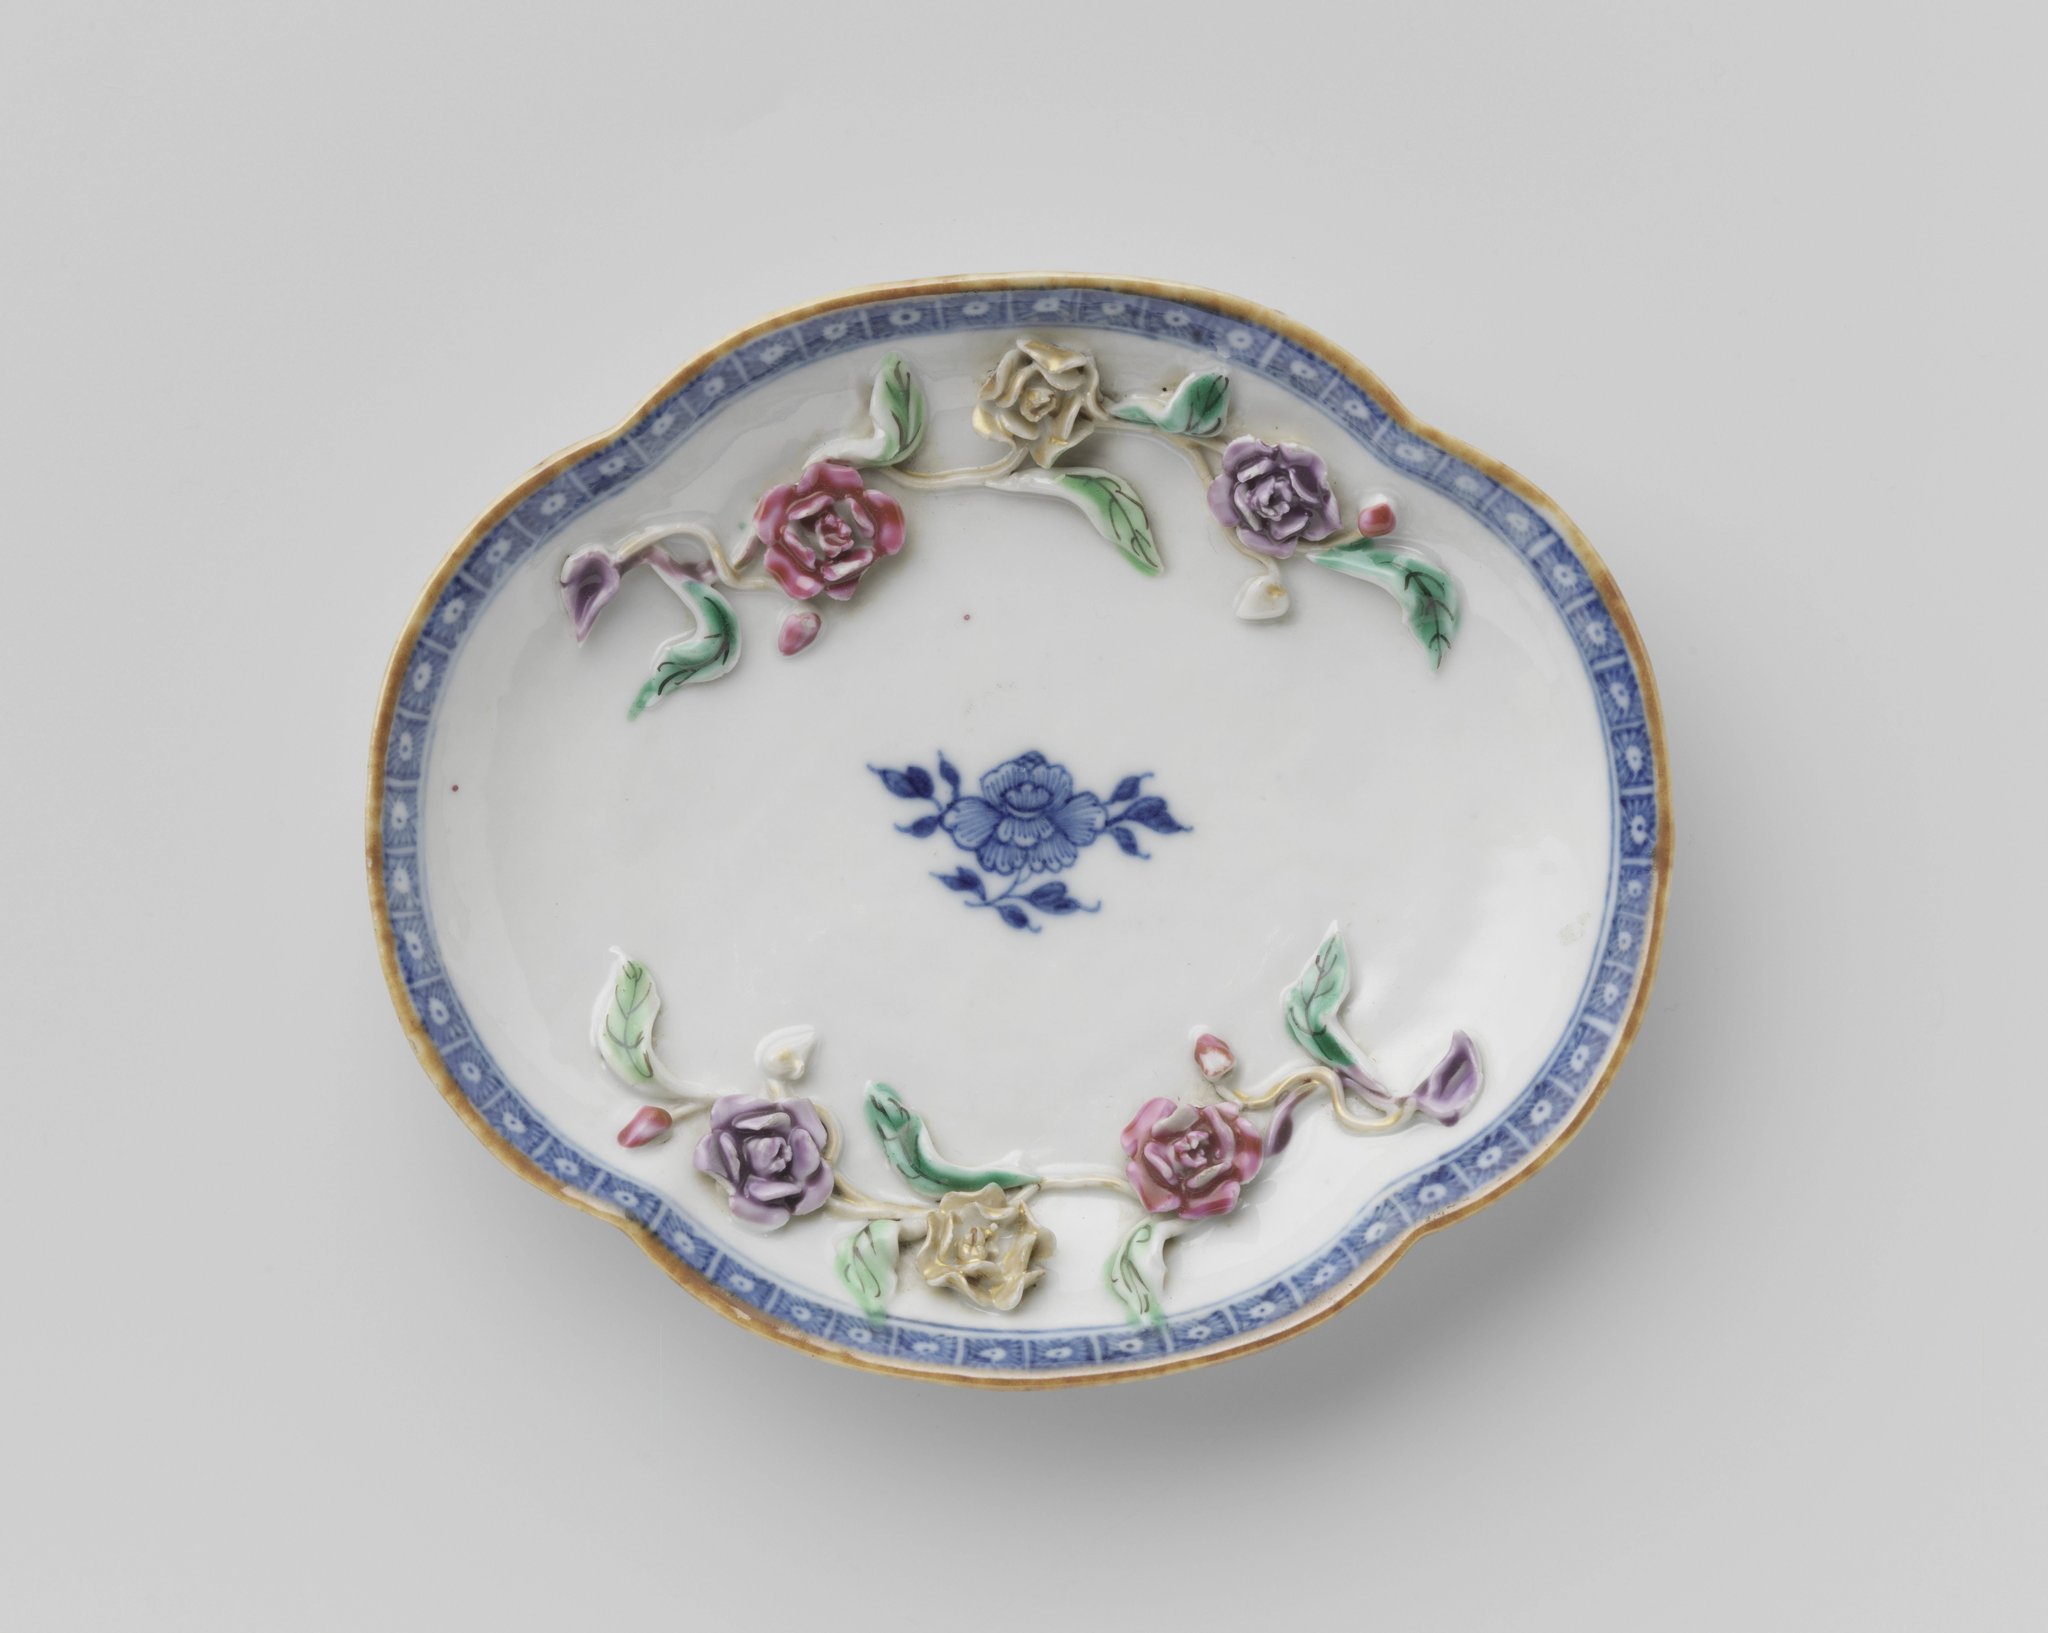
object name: kop en schotel, kop en schotel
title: Saucer with moulded flower sprays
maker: Anonymous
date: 1750-1774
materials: glaze, gold, paint, porcelain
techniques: firing, forming, gilding, turning, vitrification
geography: china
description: Kop en schotel, versierd met gekleurde bloemen in relief en blauwe rand.